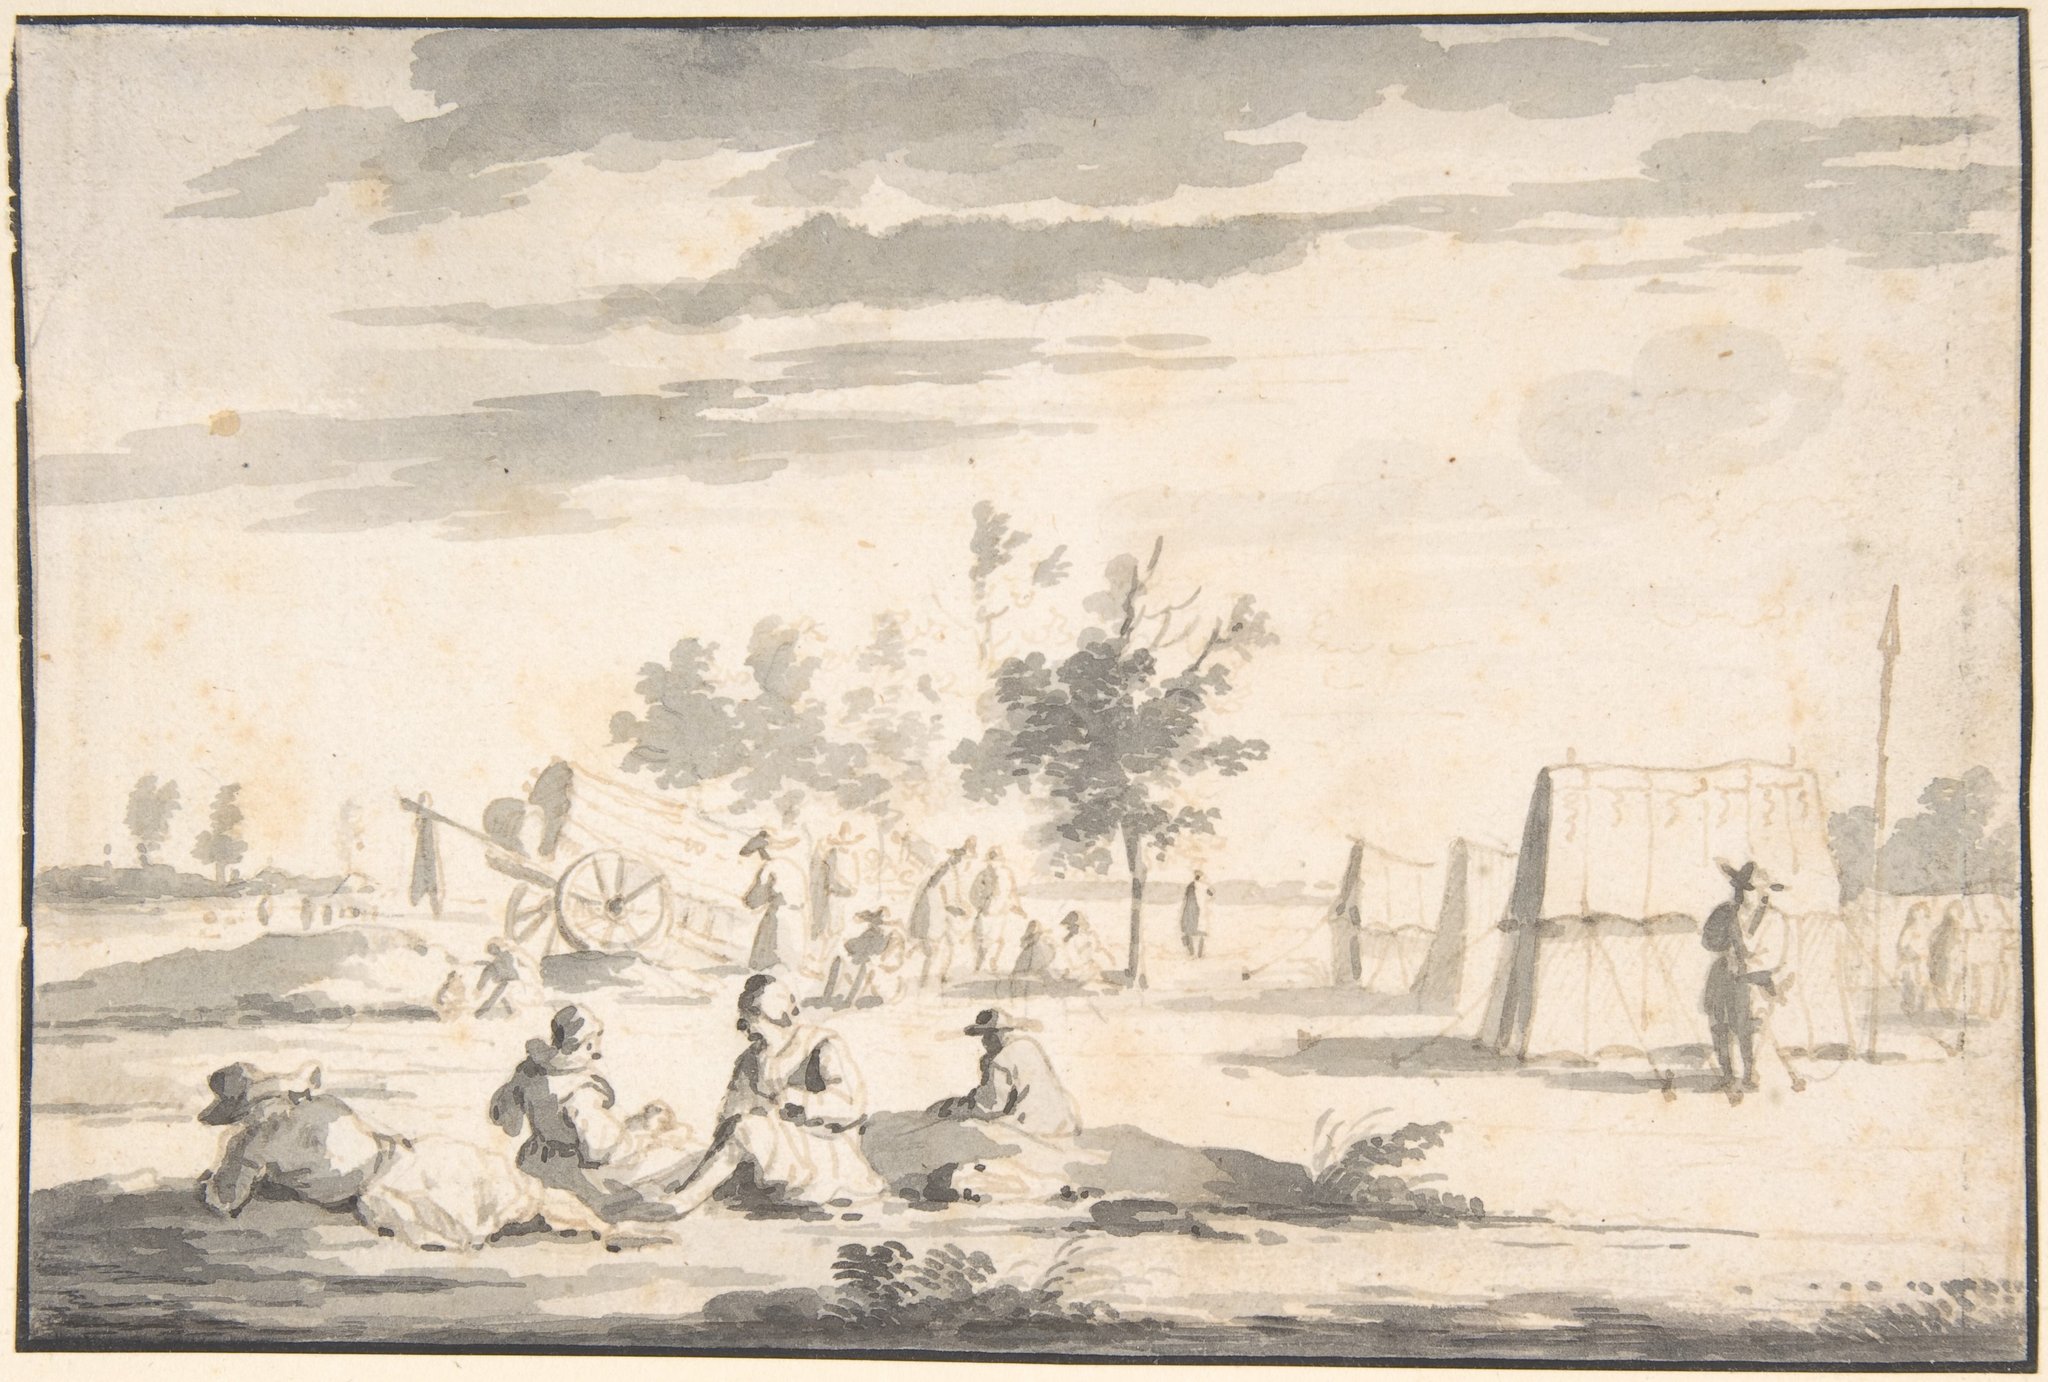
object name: drawing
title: Landscape with Figures and Camp Site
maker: josua de grave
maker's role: artist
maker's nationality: dutch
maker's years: 1643-1712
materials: chalk, ink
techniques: pen, wash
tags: human figures,tents,landscapes